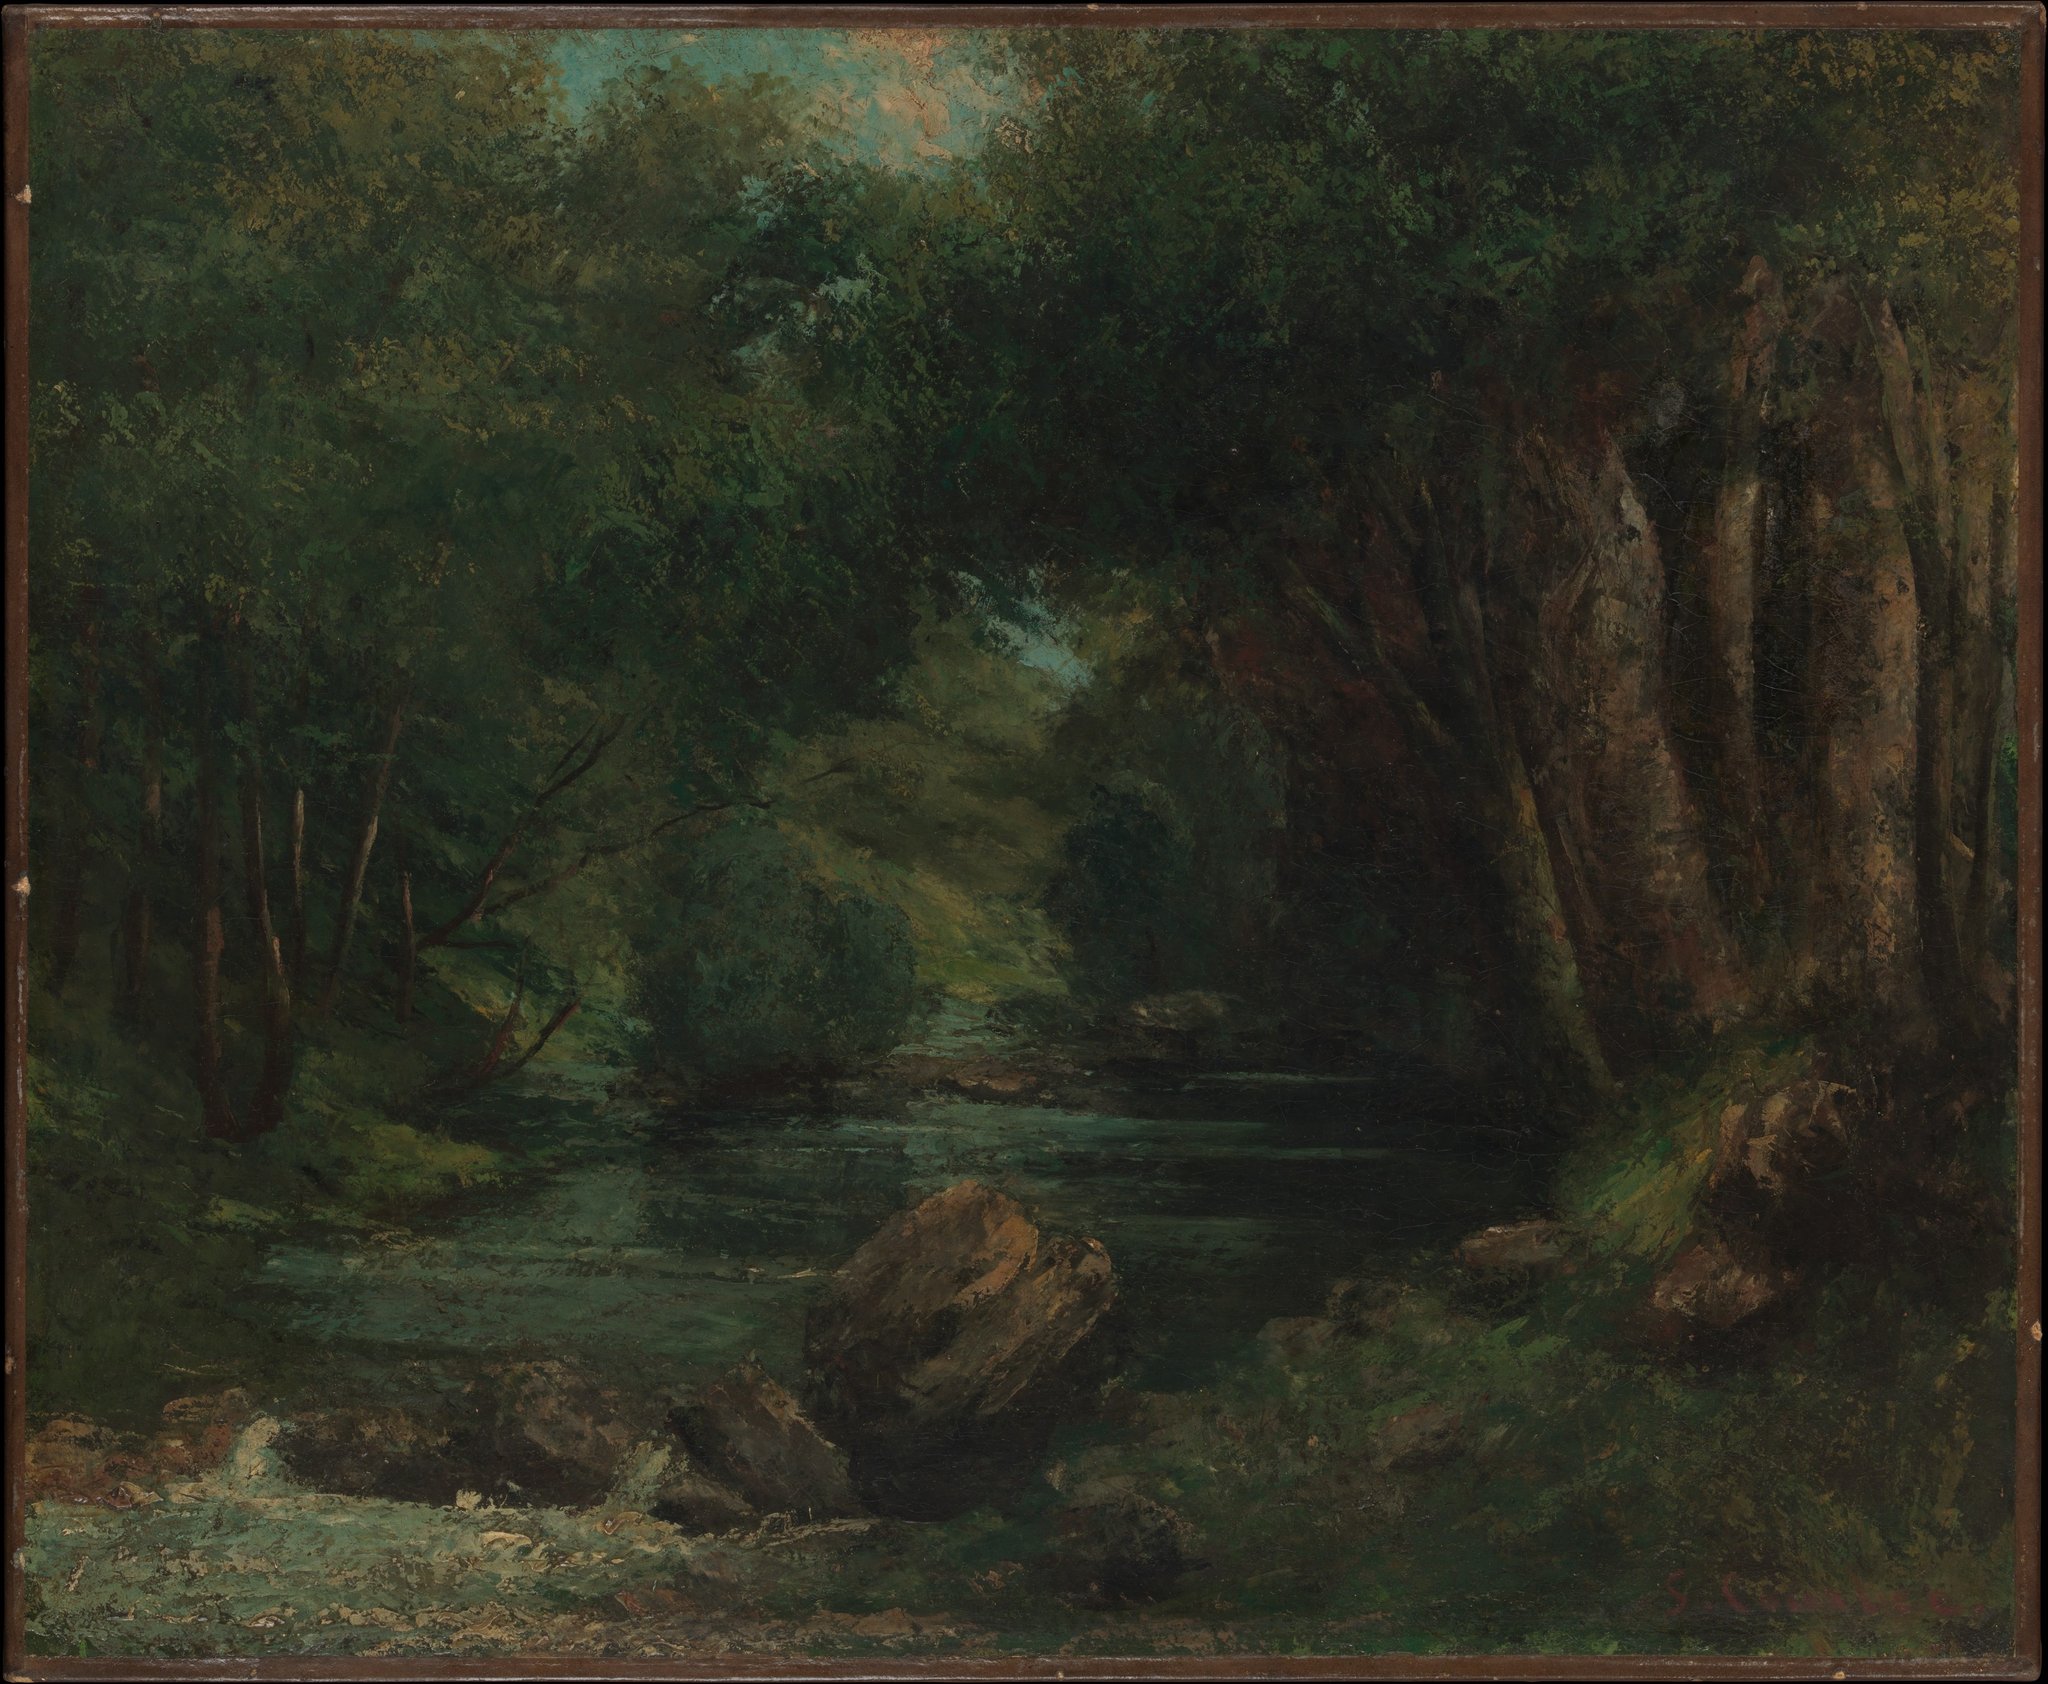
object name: painting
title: A Brook in the Forest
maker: gustave courbet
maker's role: artist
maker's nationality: french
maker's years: 1819-1877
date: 1868-1877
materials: canvas, oil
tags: forests,landscapes,streams